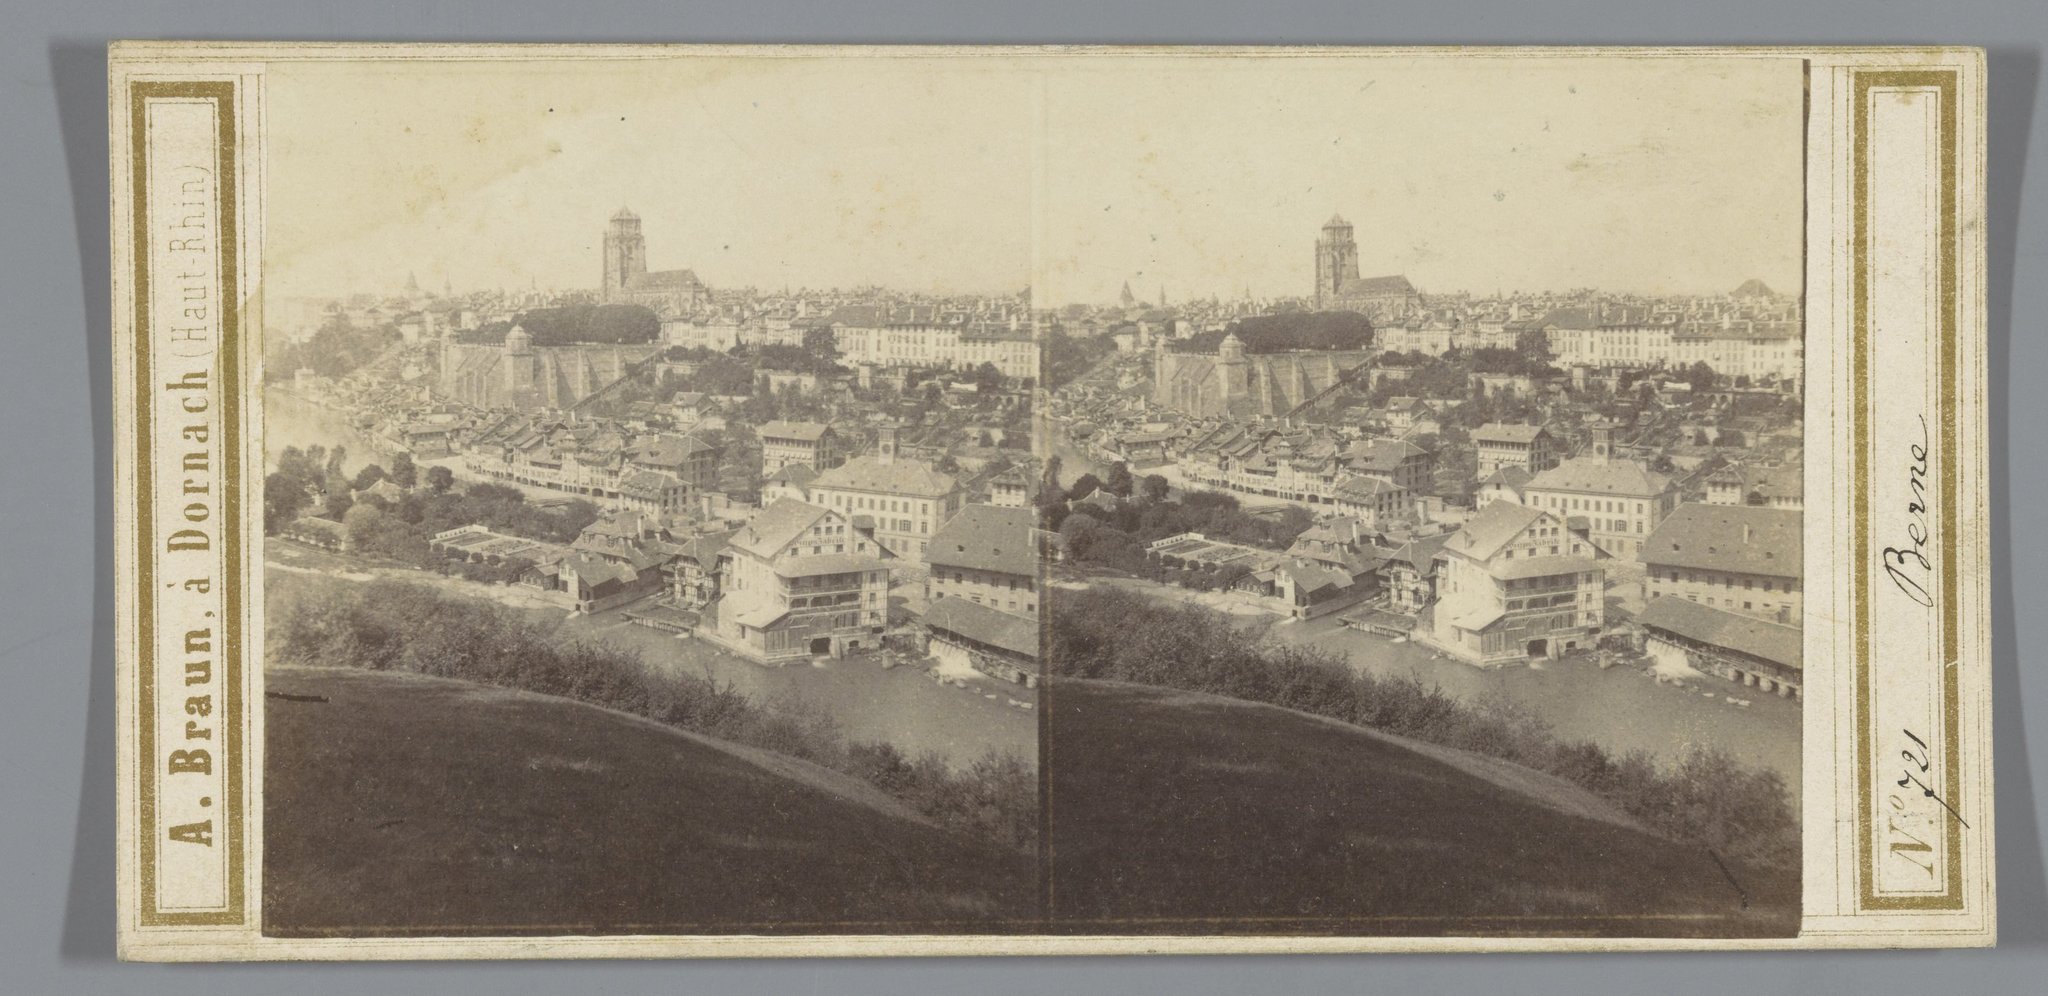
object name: stereograph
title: Berne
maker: Anonymous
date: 1860-1866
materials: cardboard, paper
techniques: albumen print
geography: dornach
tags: city-view in general; 'veduta'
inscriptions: number: ‘No. 721’